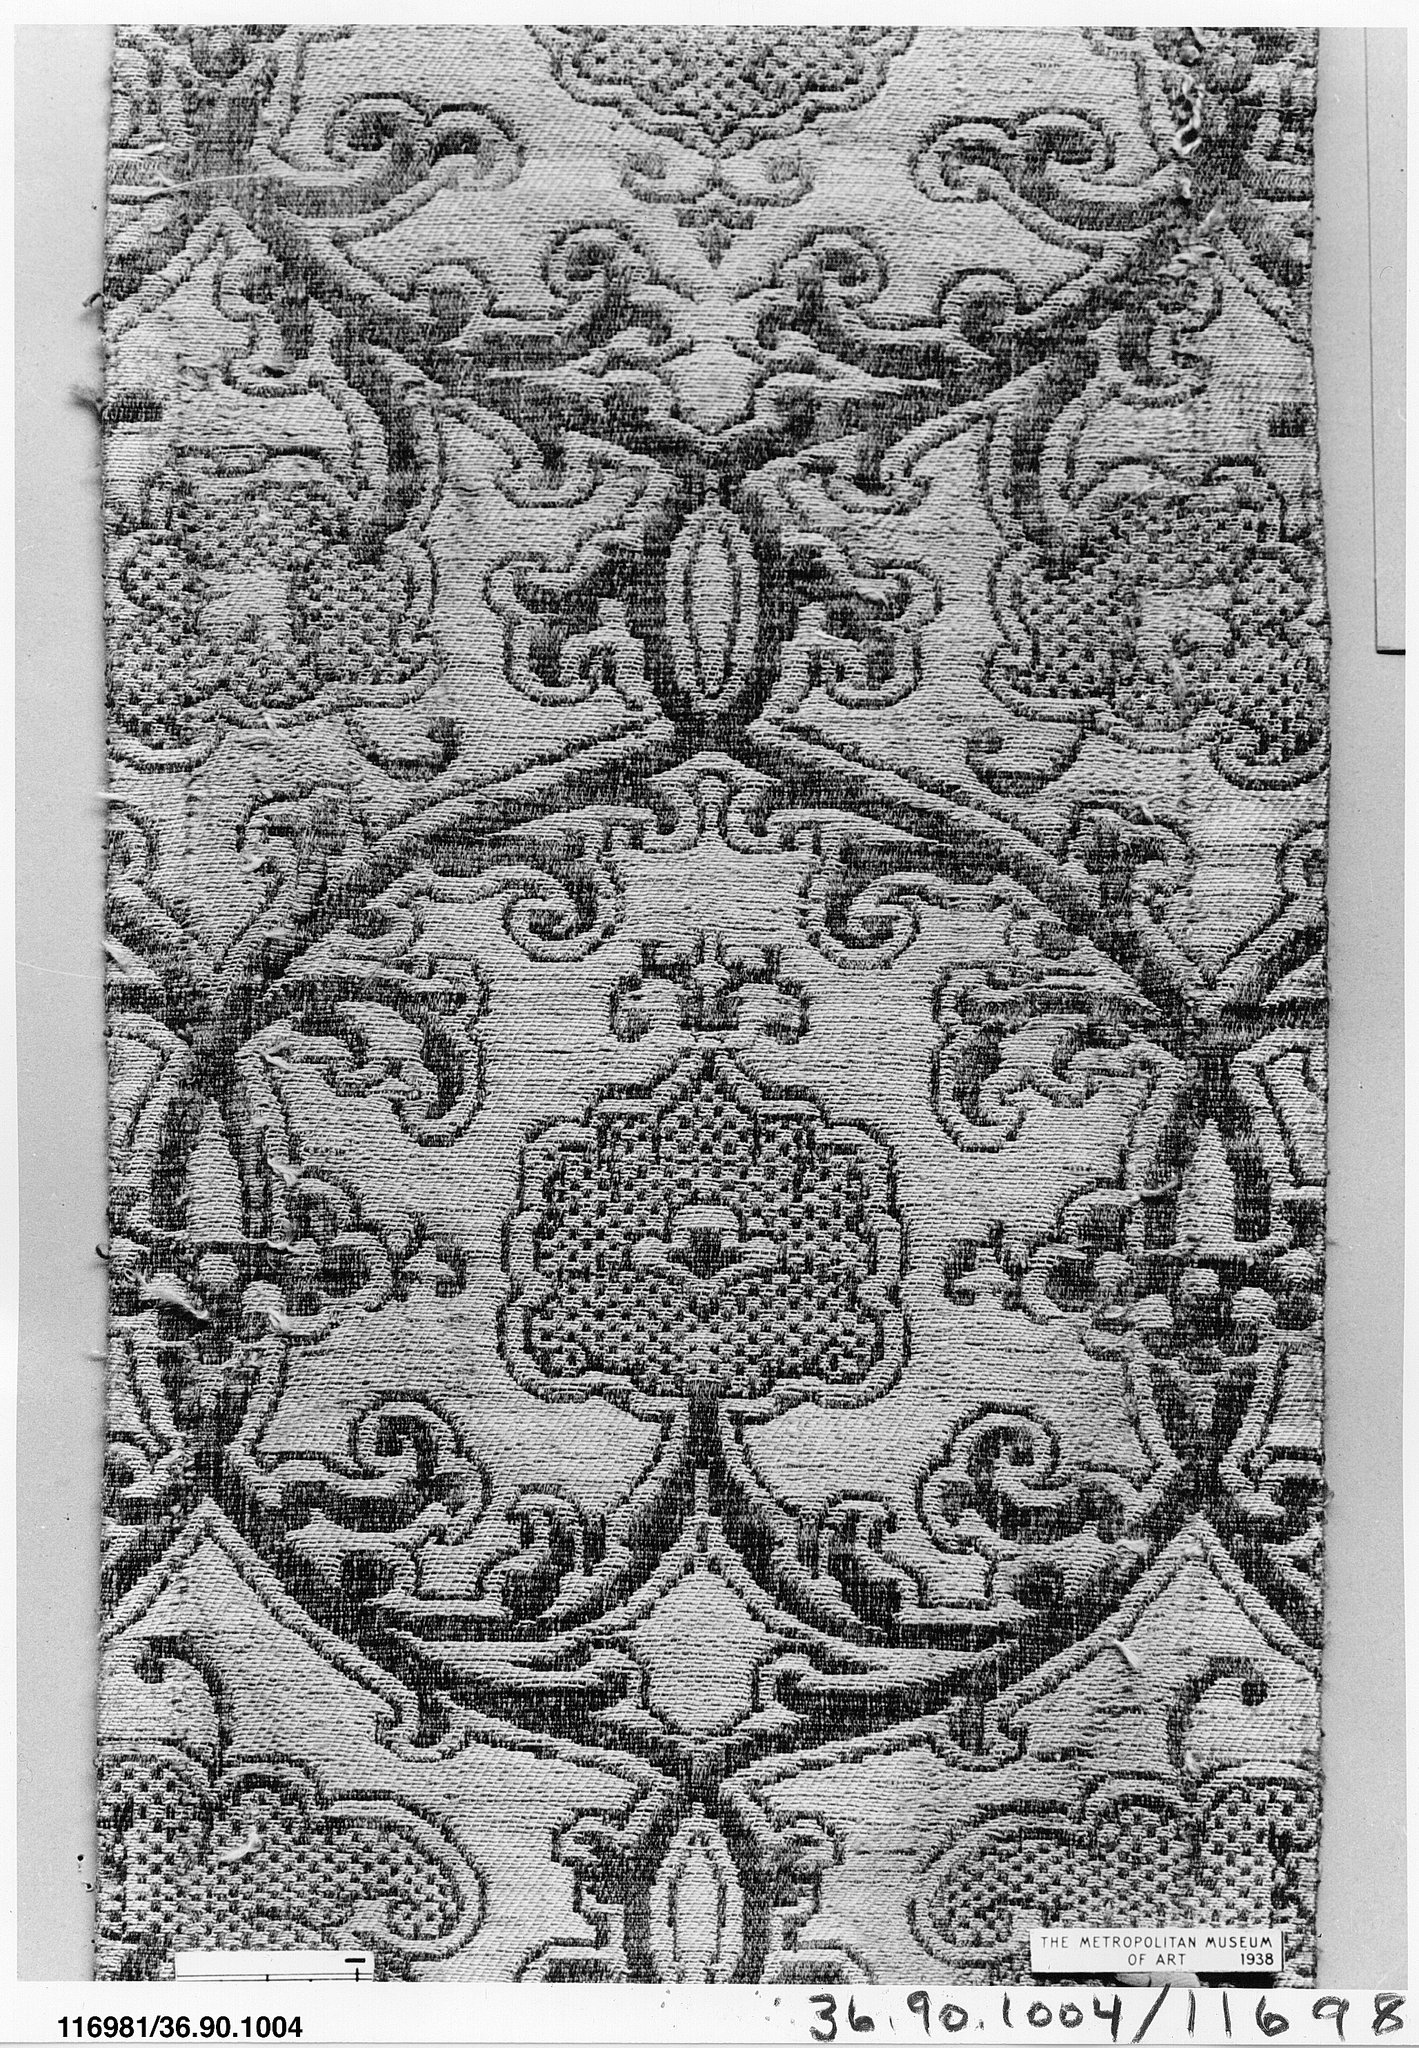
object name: piece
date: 1501-1600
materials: cotton, silk